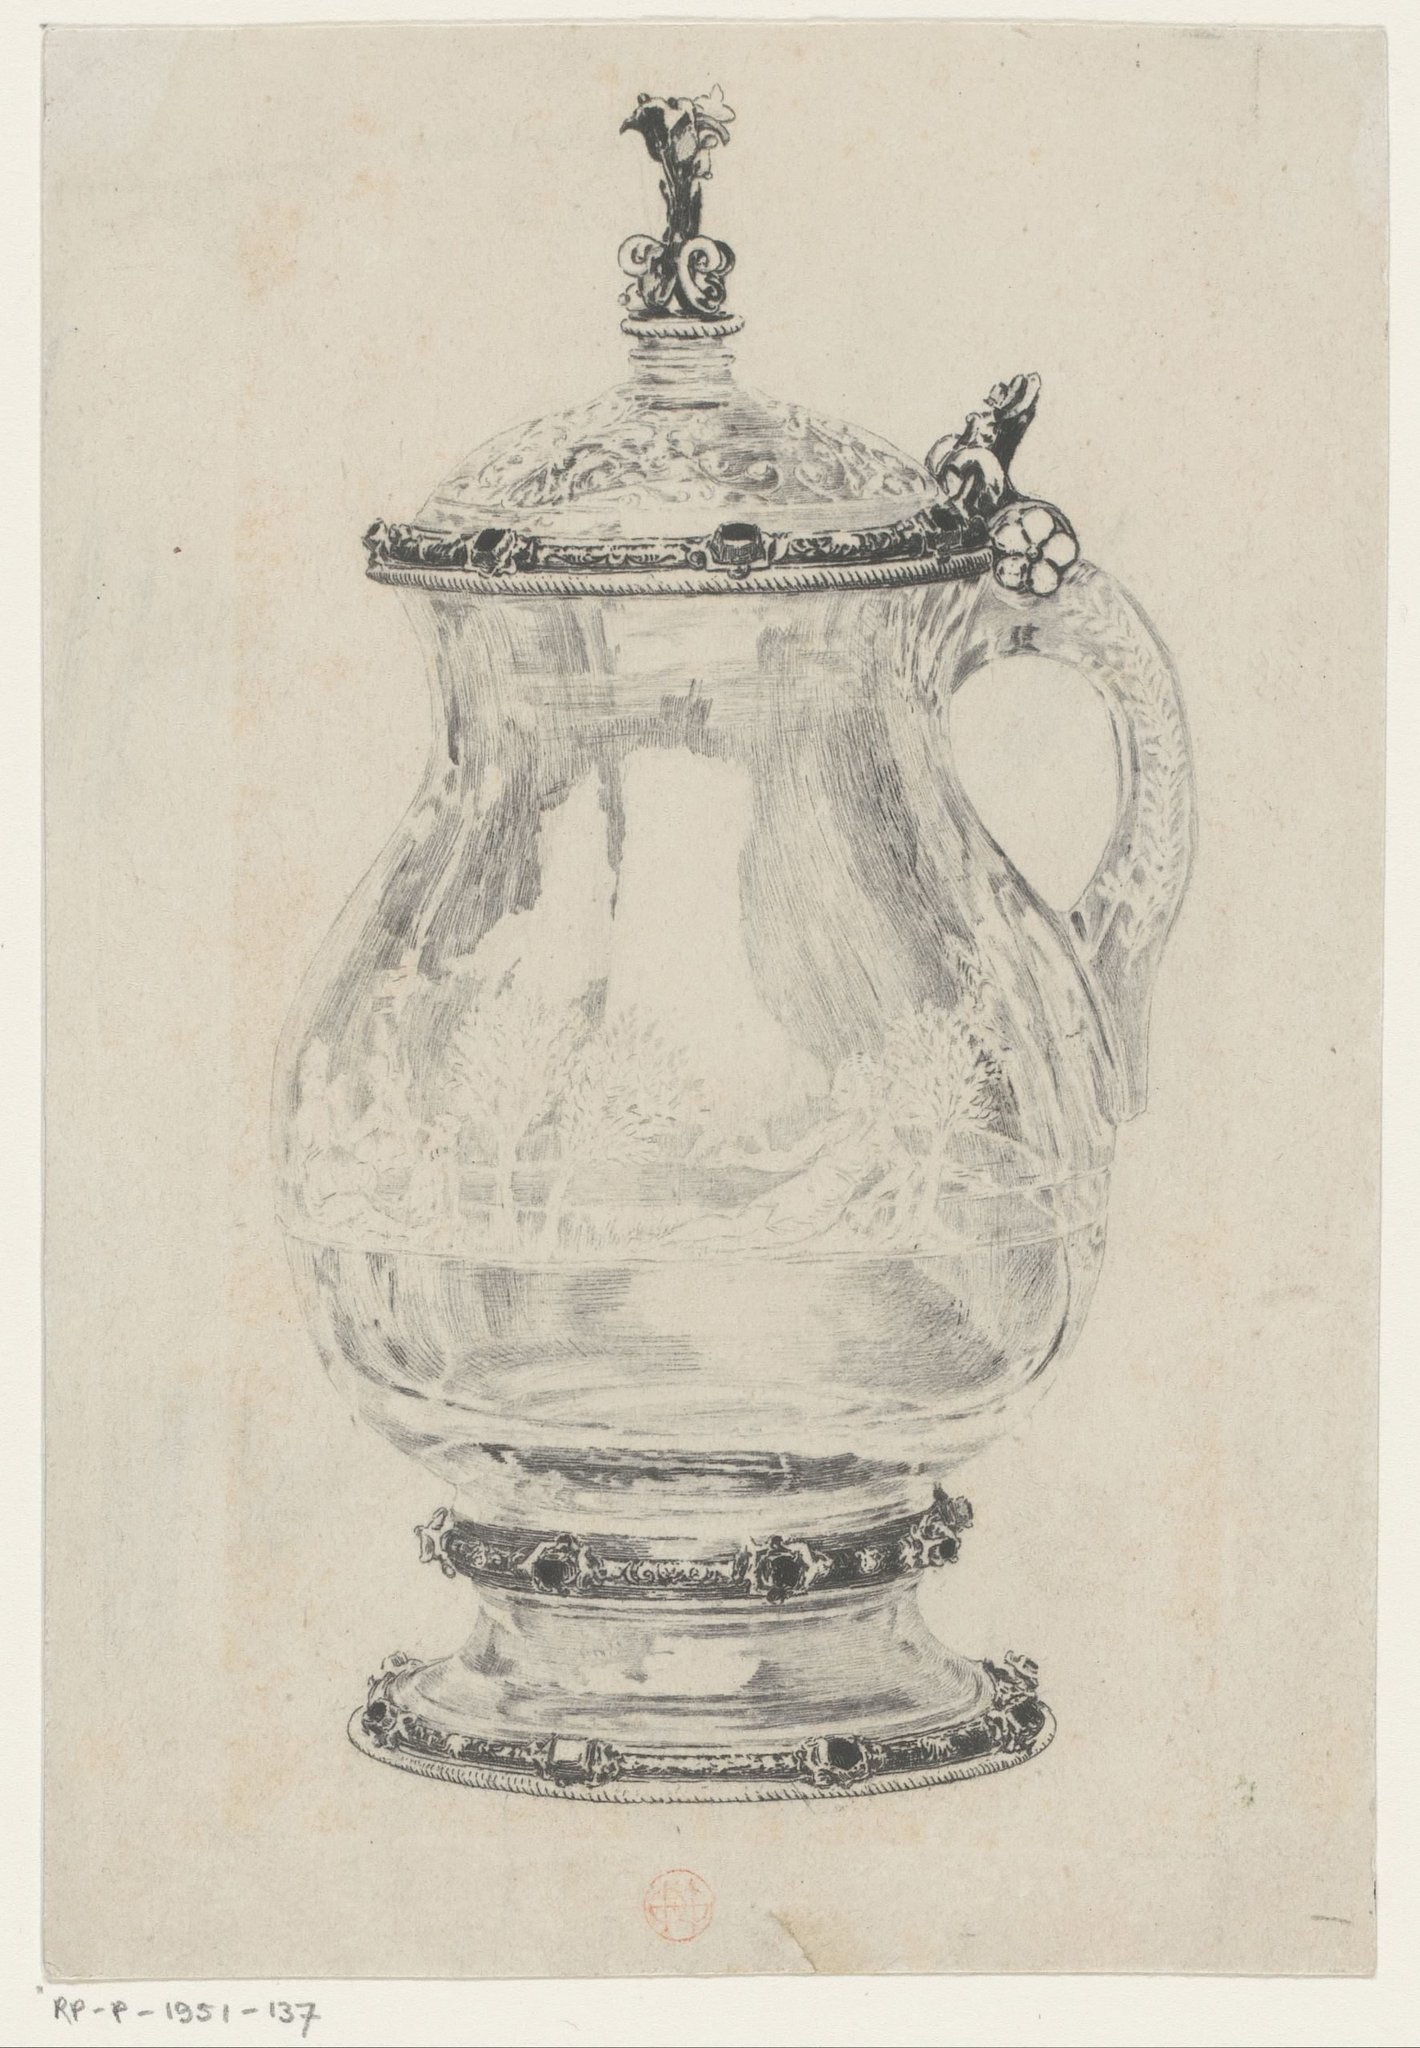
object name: print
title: Kristallen kan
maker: henri charles guérard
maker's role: print maker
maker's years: 1846-1897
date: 1856-1897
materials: paper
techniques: etching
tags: containers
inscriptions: stamp: Lugt 1157, collector's mark: Lugt 2228